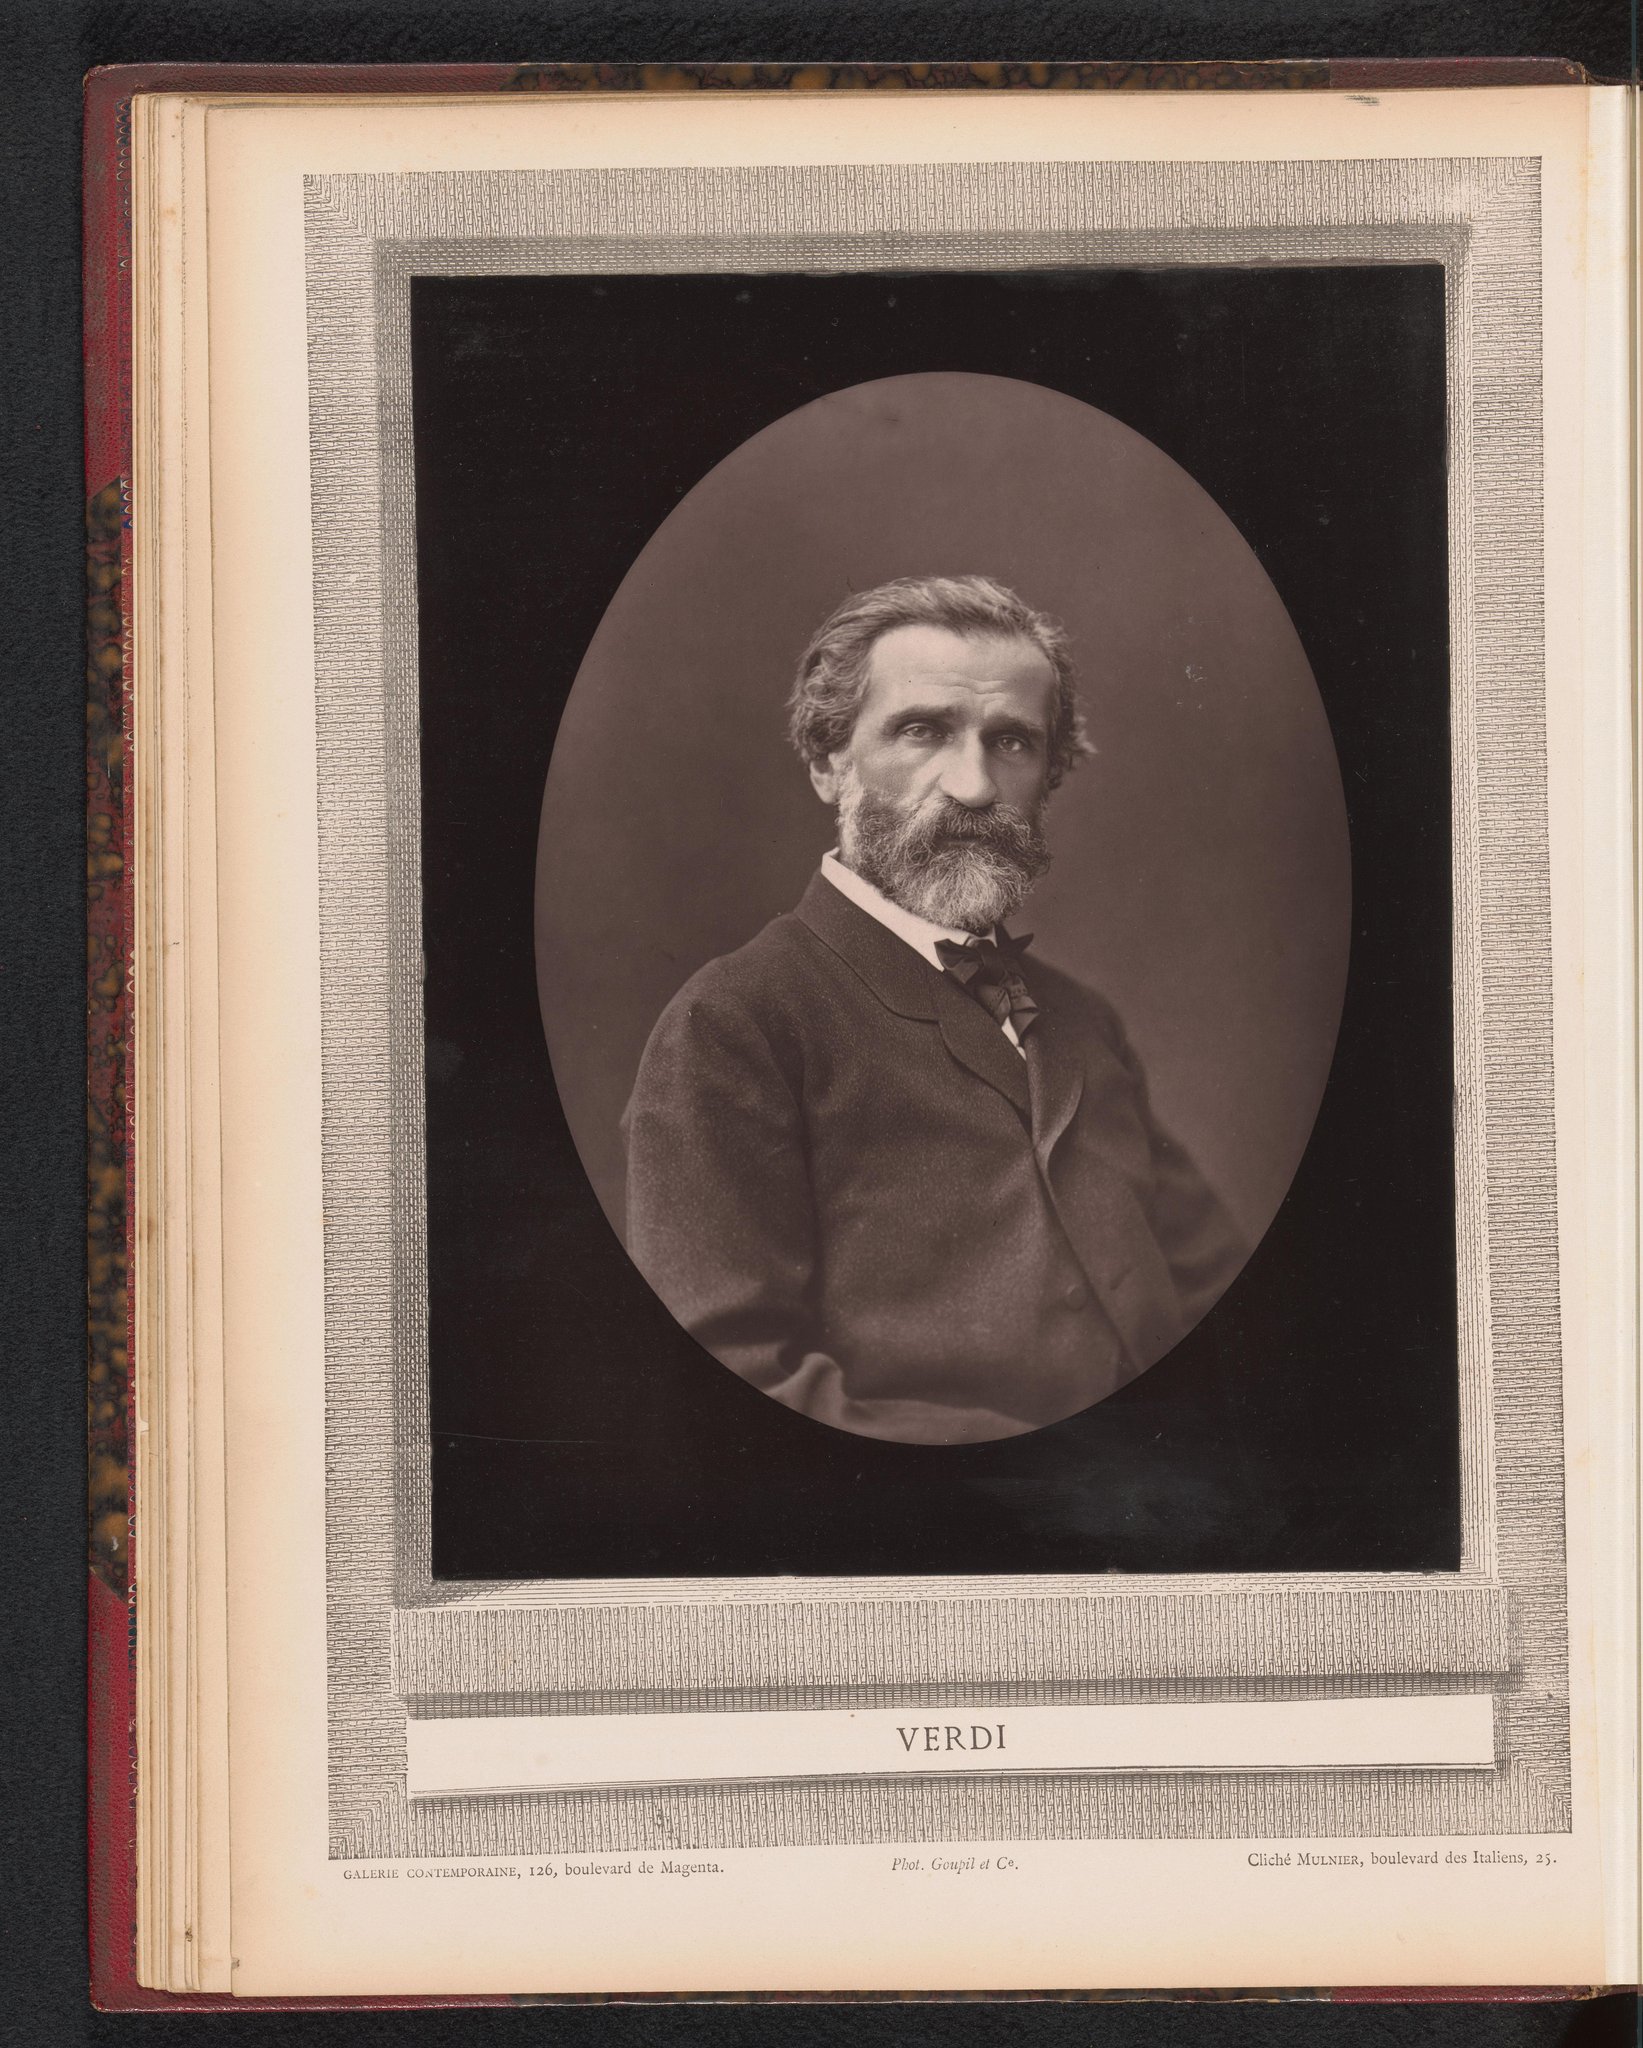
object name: photomechanical print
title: Portret van Giuseppe Verdi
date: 1872-1877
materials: paper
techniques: woodburytype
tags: italy, adult man, historical persons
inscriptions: inscription: ‘Galerie Contemporaine, 126, boulevard de Magenta.’